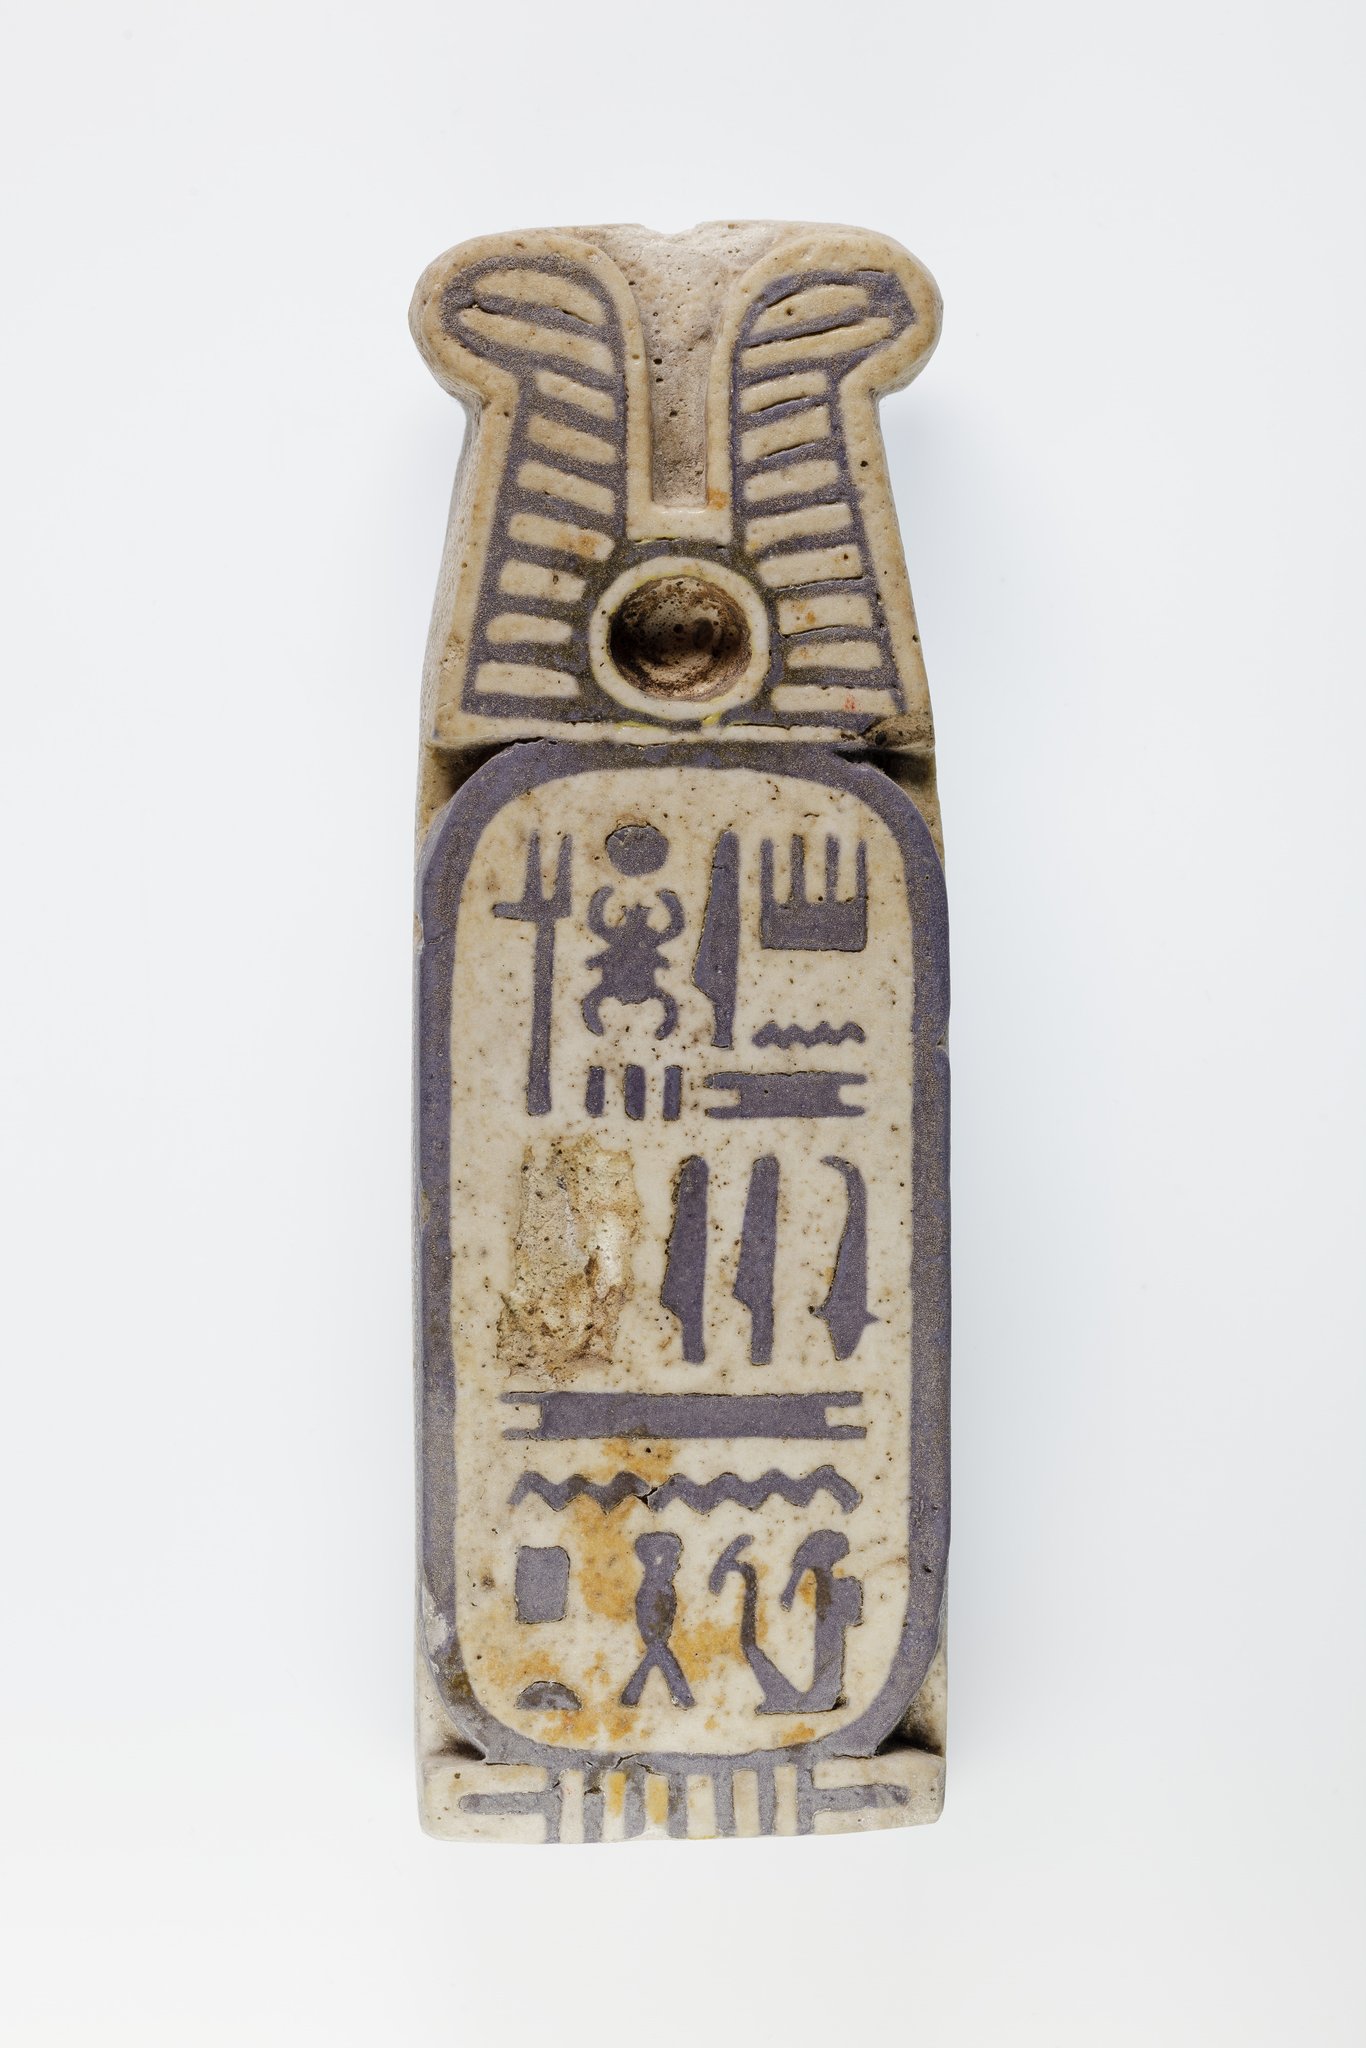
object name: plaque, seti ii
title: Inlay Representing the Cartouche of Seti II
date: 1200-1194 BCE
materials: faience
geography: egypt